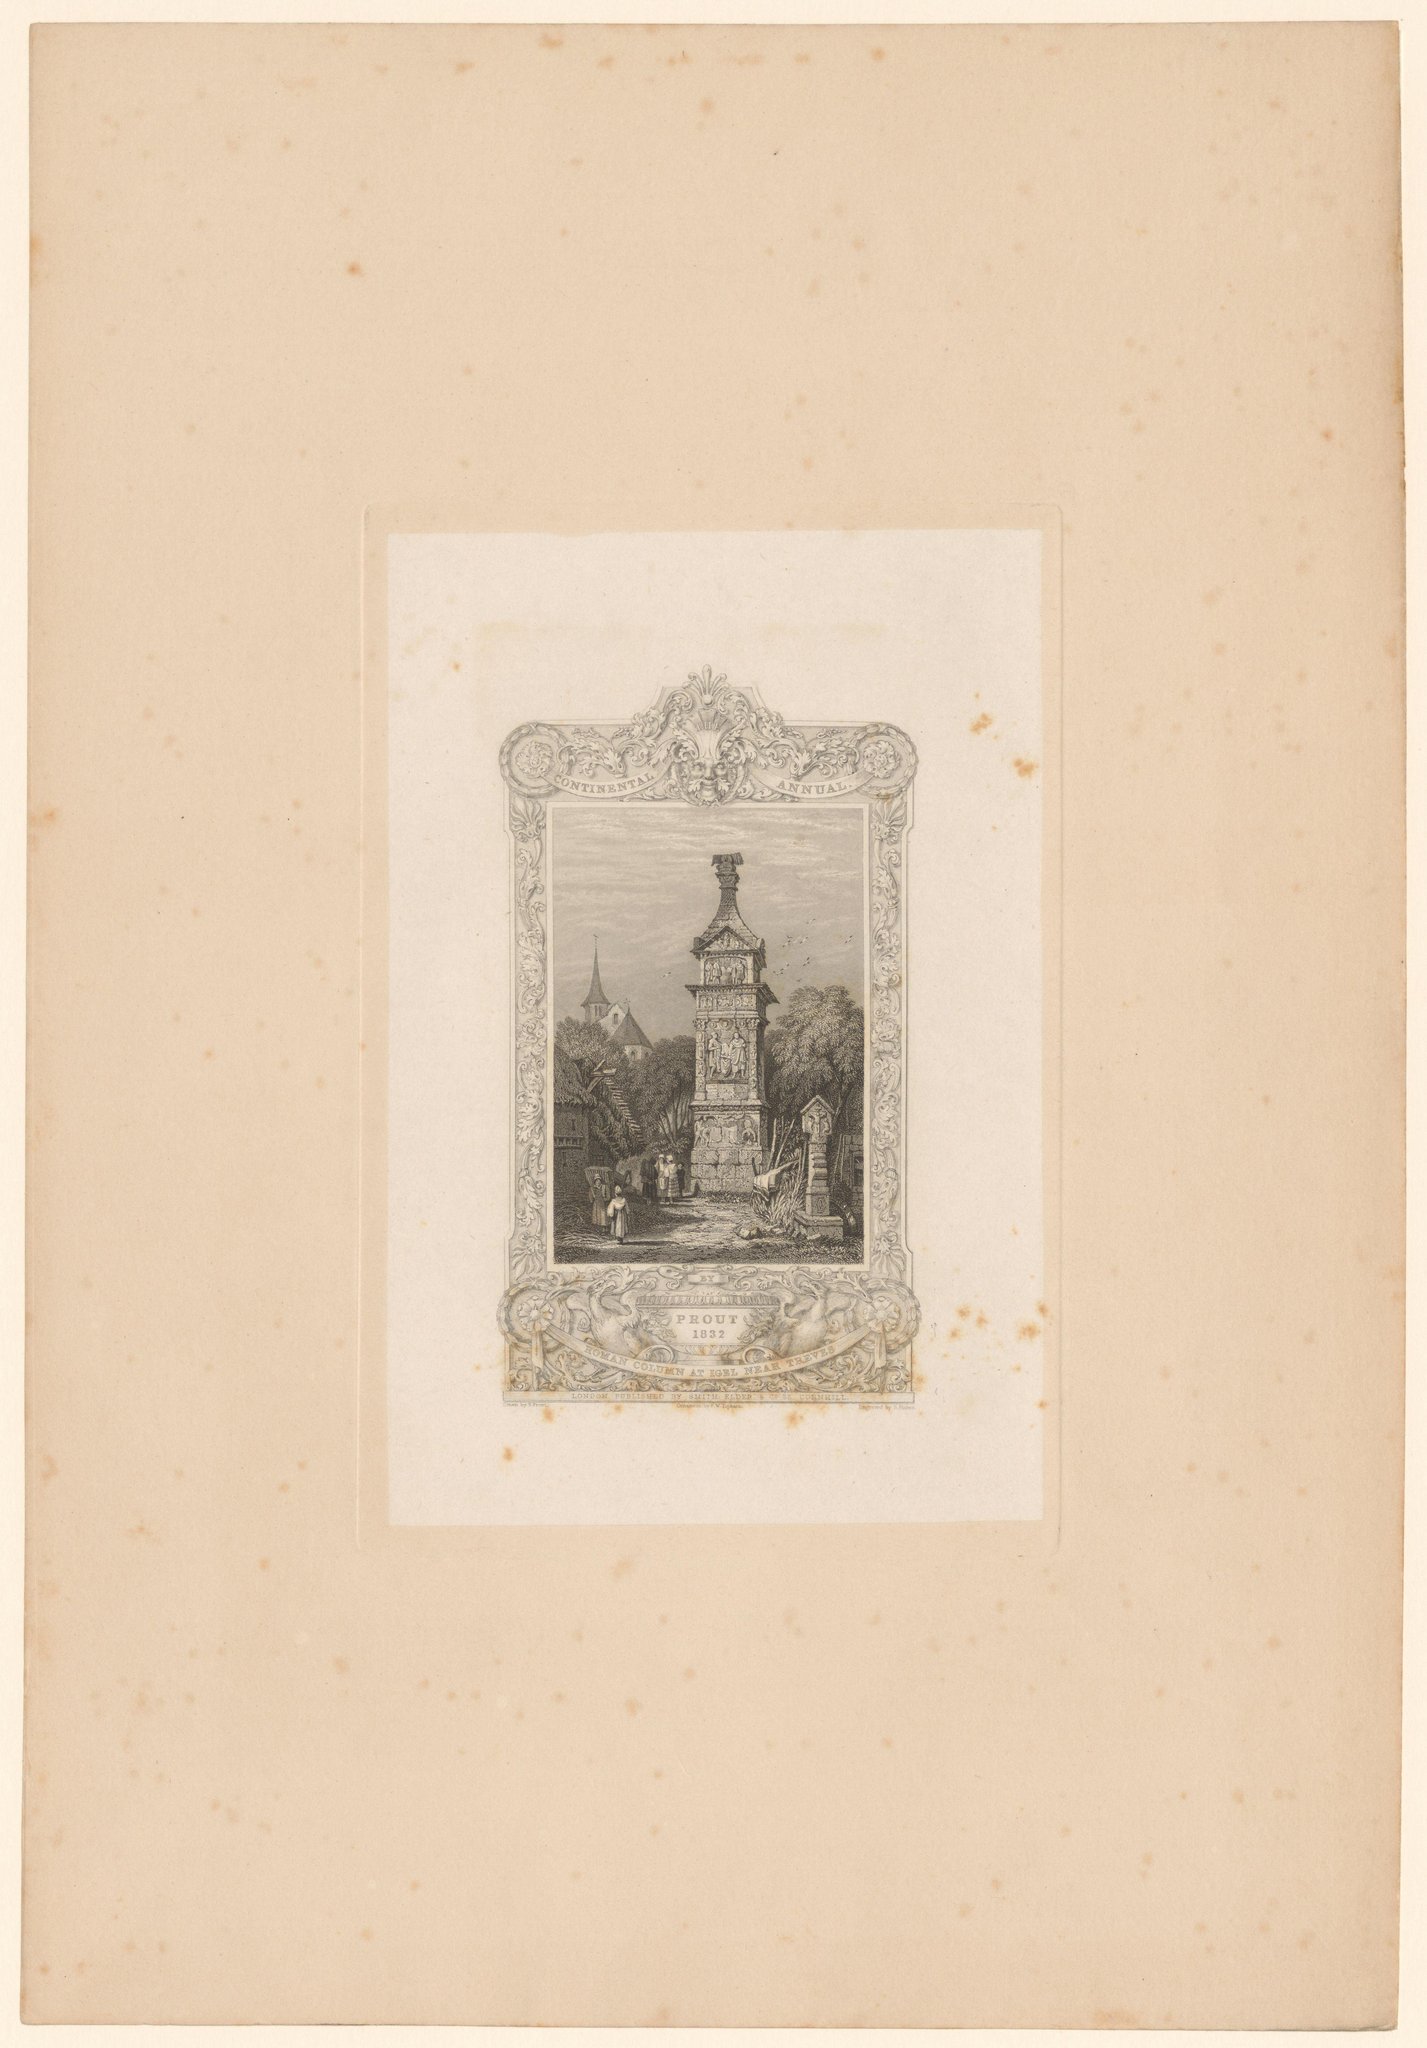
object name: print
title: Gezicht op de Igeler Säule bij Trier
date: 1832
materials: paper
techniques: engraving, etching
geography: london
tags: monumental adornments (in city)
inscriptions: collector's mark: Lugt 2228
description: Prent gebruikt in: Kennedy, William. The Continental Annual and Romantic Cabinet, For 1832. Londen: Smith, Elder & Co., 1832.